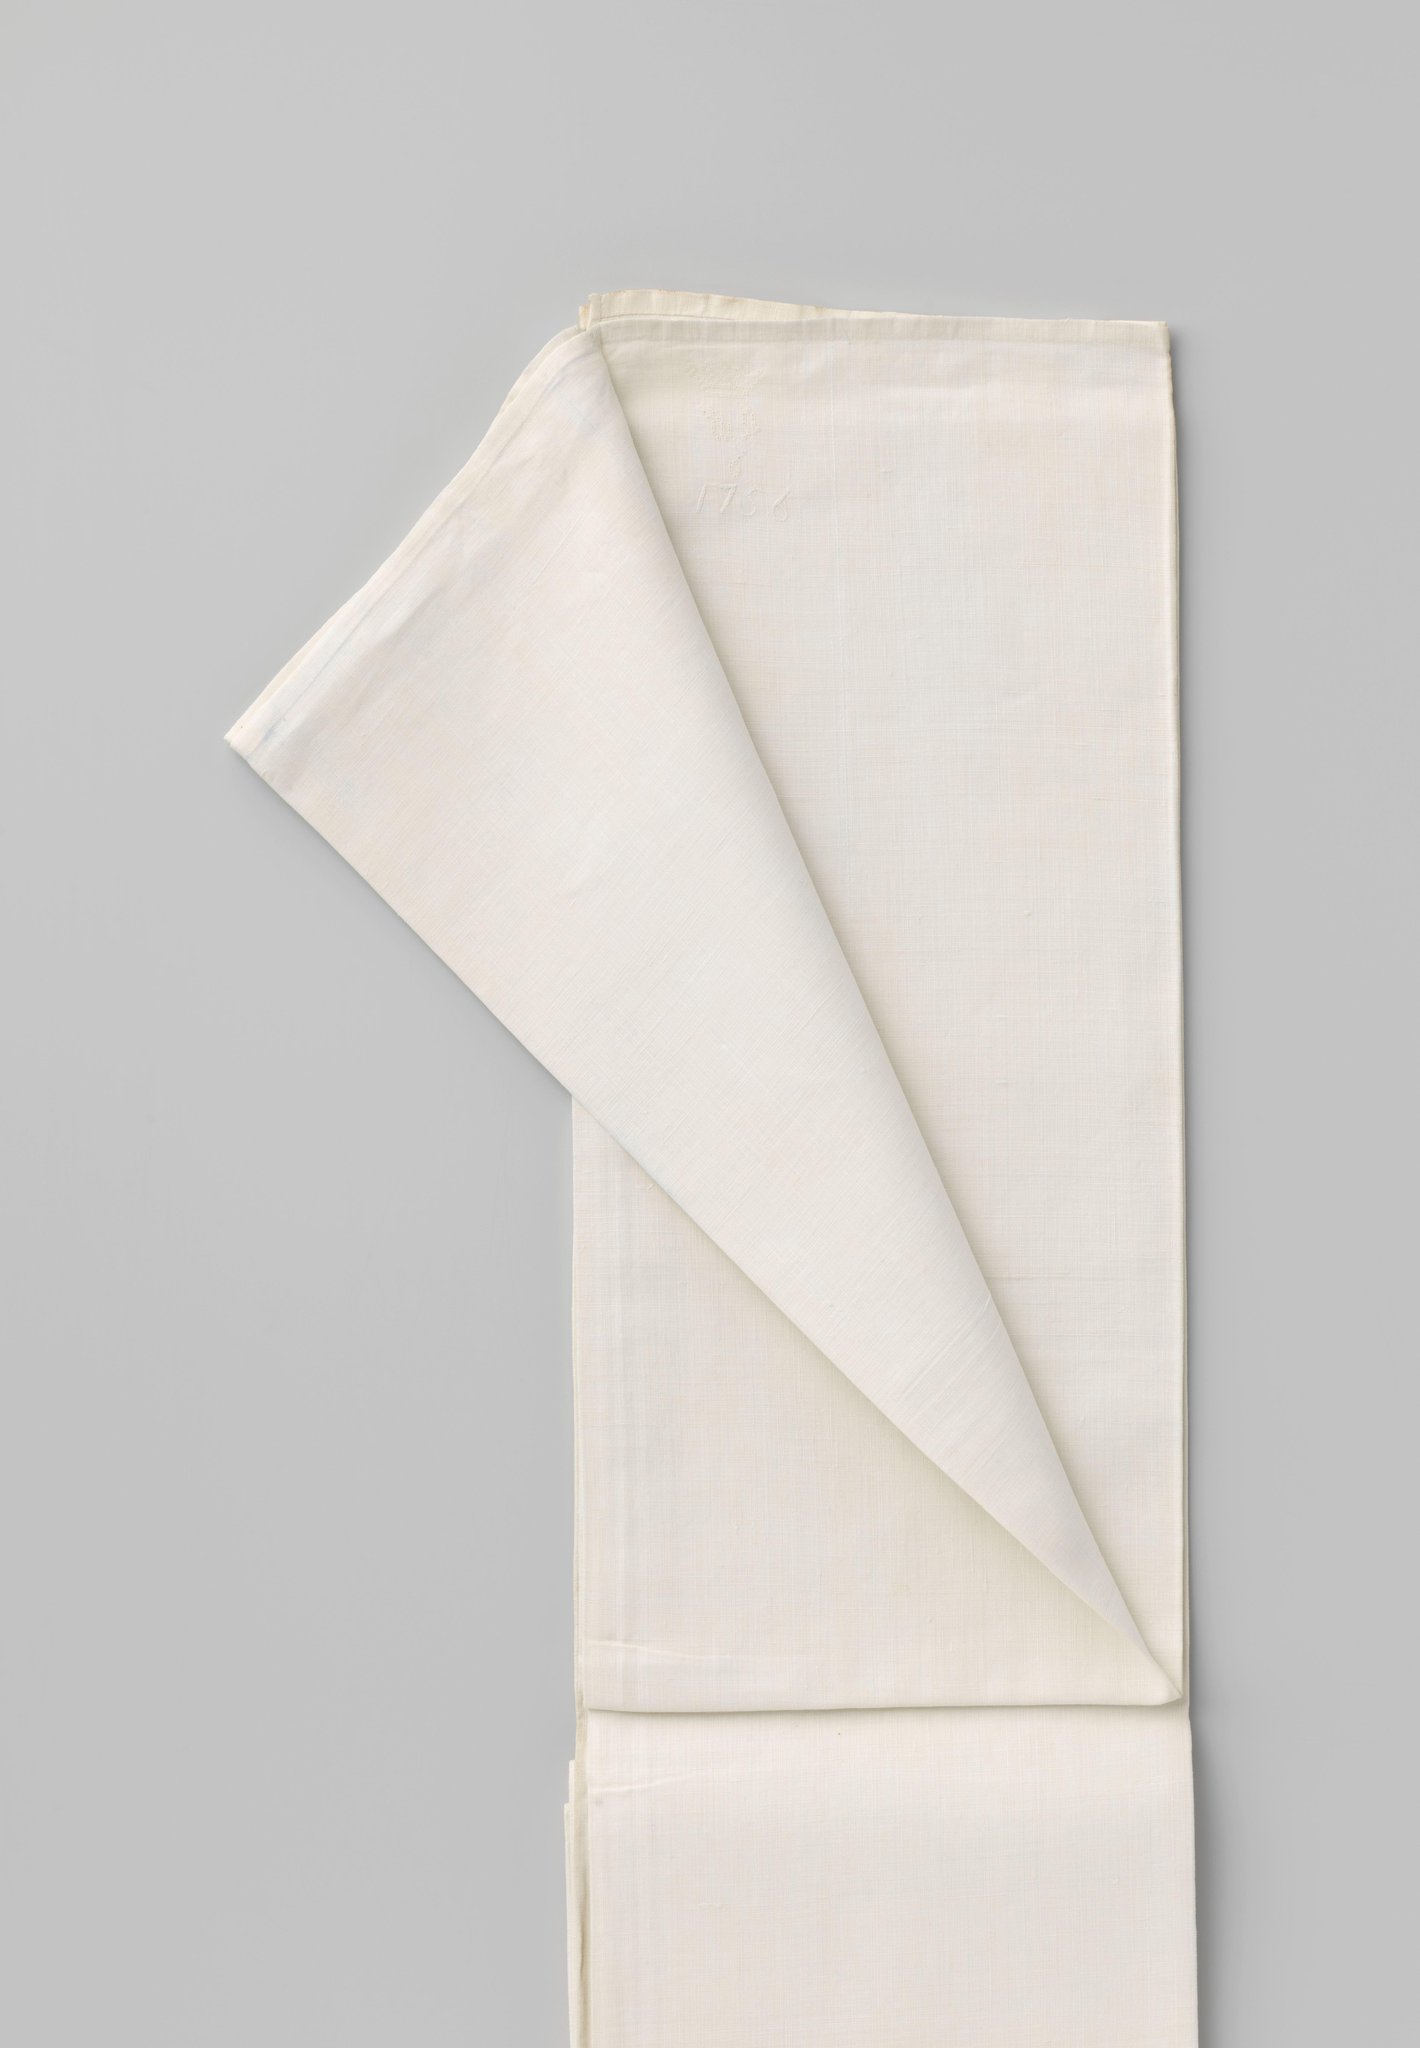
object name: beddenlaken, laken object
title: Laken. Merk: kroon WG6 en jaartal 1756.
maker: Anonymous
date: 1756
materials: linen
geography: northern netherlands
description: Laken van wit linnen, merk kroon WG 6 1756